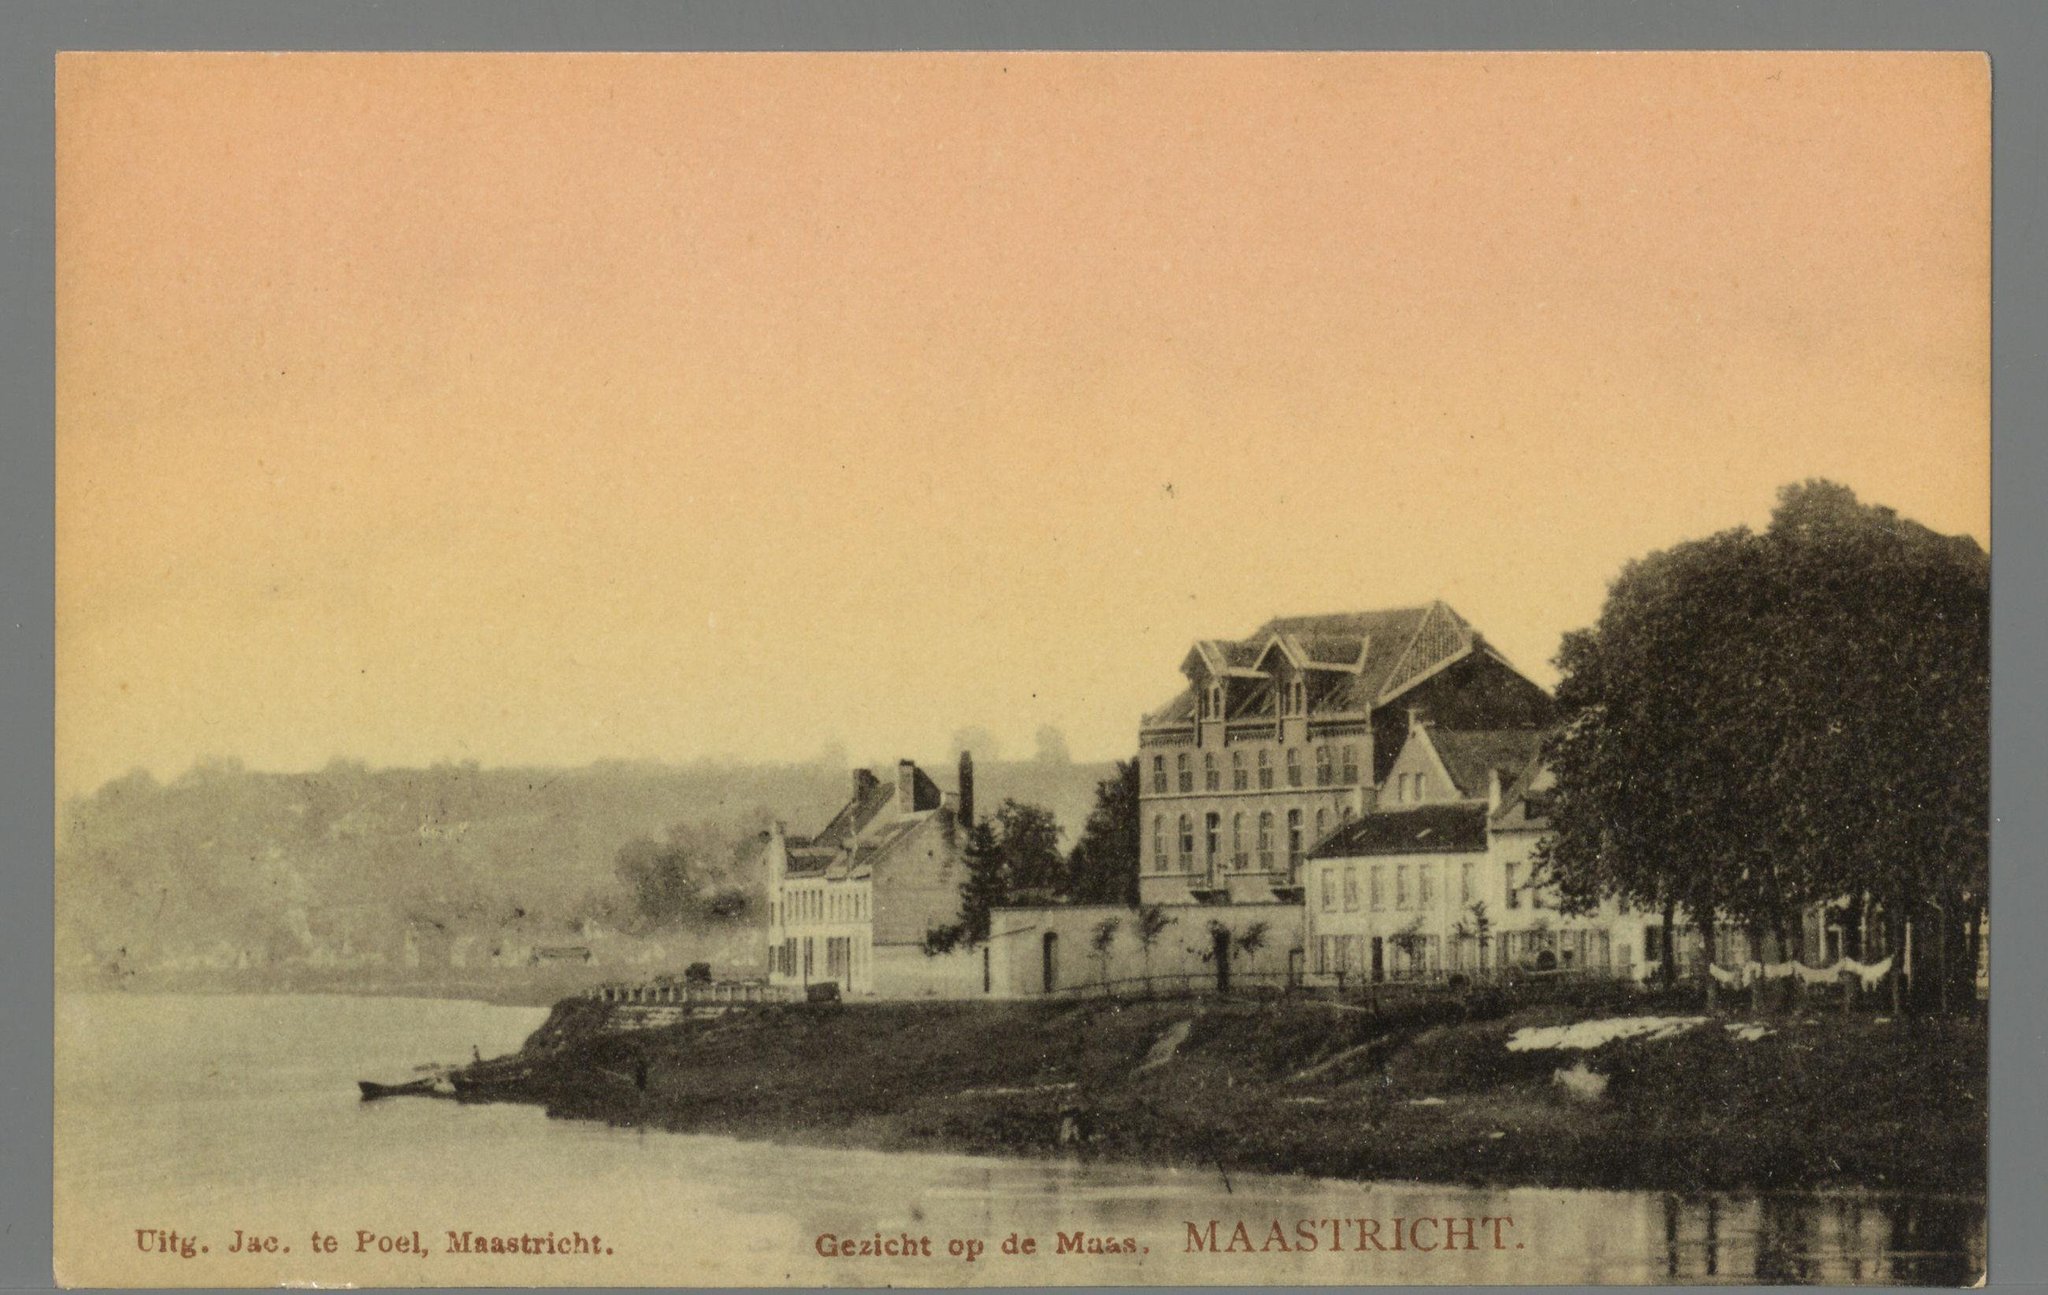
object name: photomechanical print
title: Gezicht op de Maas. Maastricht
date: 1905-1919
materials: cardboard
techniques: photograph, iris print, lithograph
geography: haarlem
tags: city-view, and landscape with man-made constructions, river